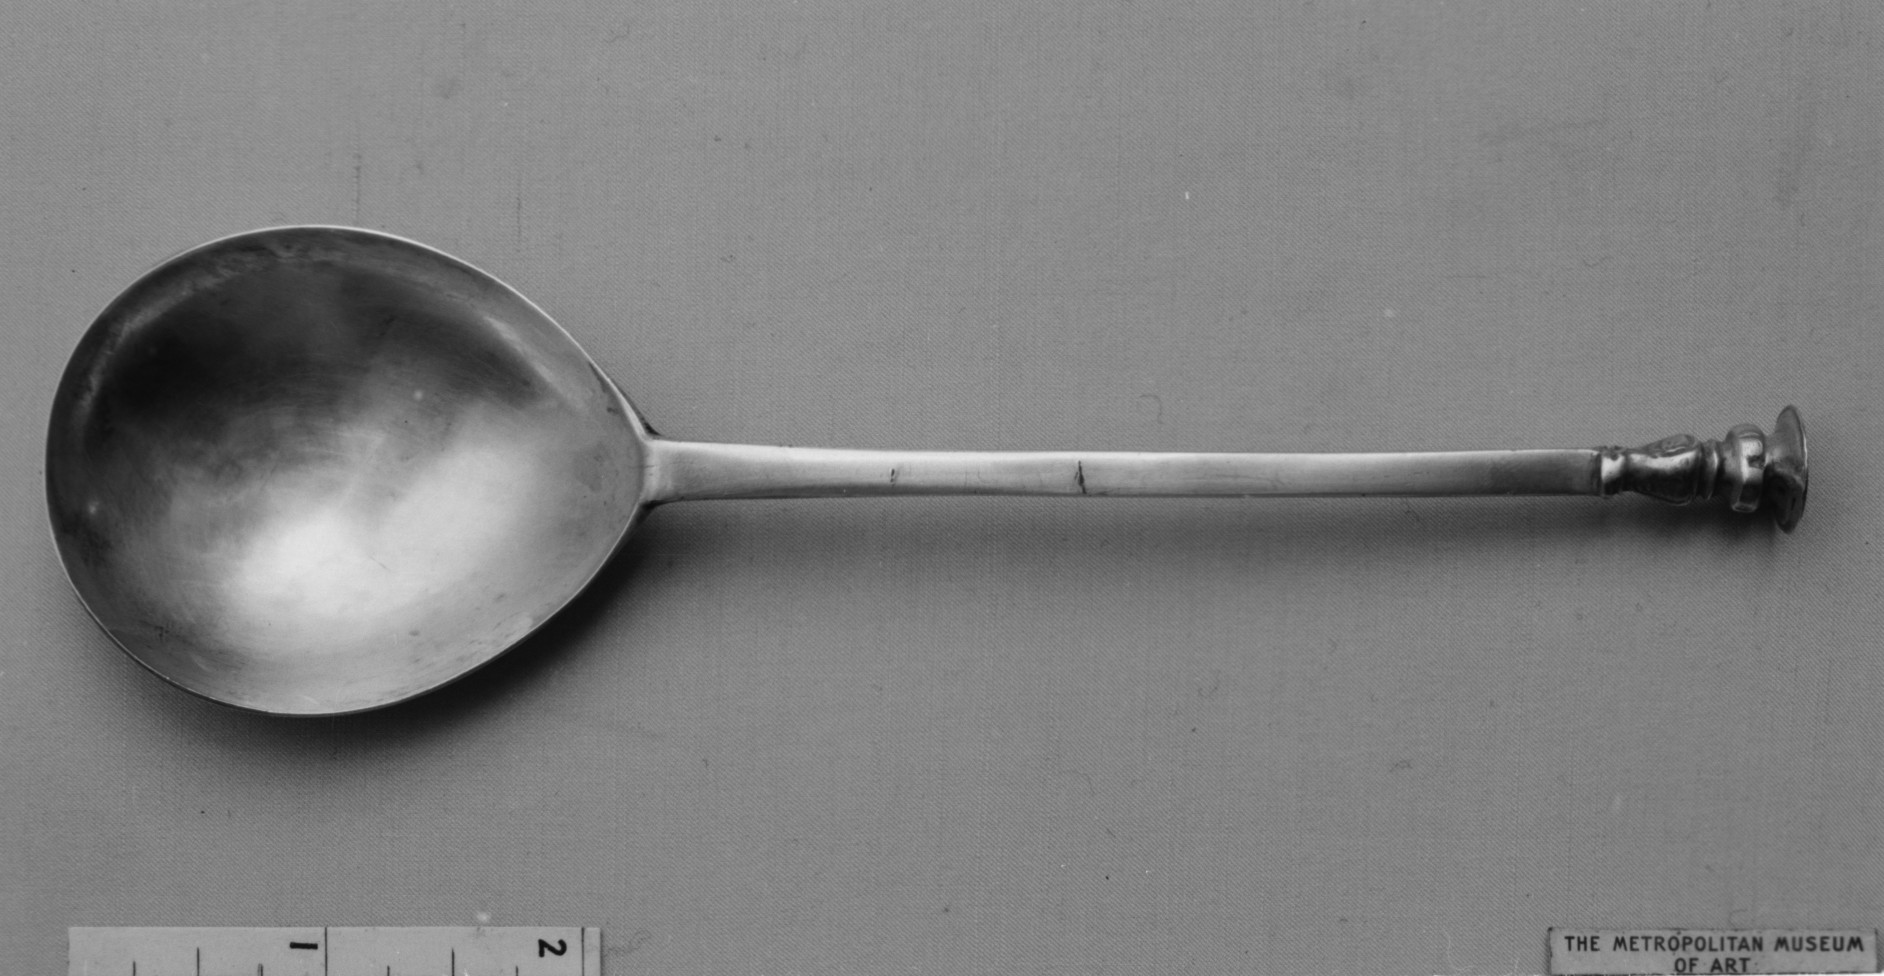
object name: spoon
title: Seal-top spoon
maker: edward pocock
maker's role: maker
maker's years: 1728-1734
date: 1735-1736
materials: silver